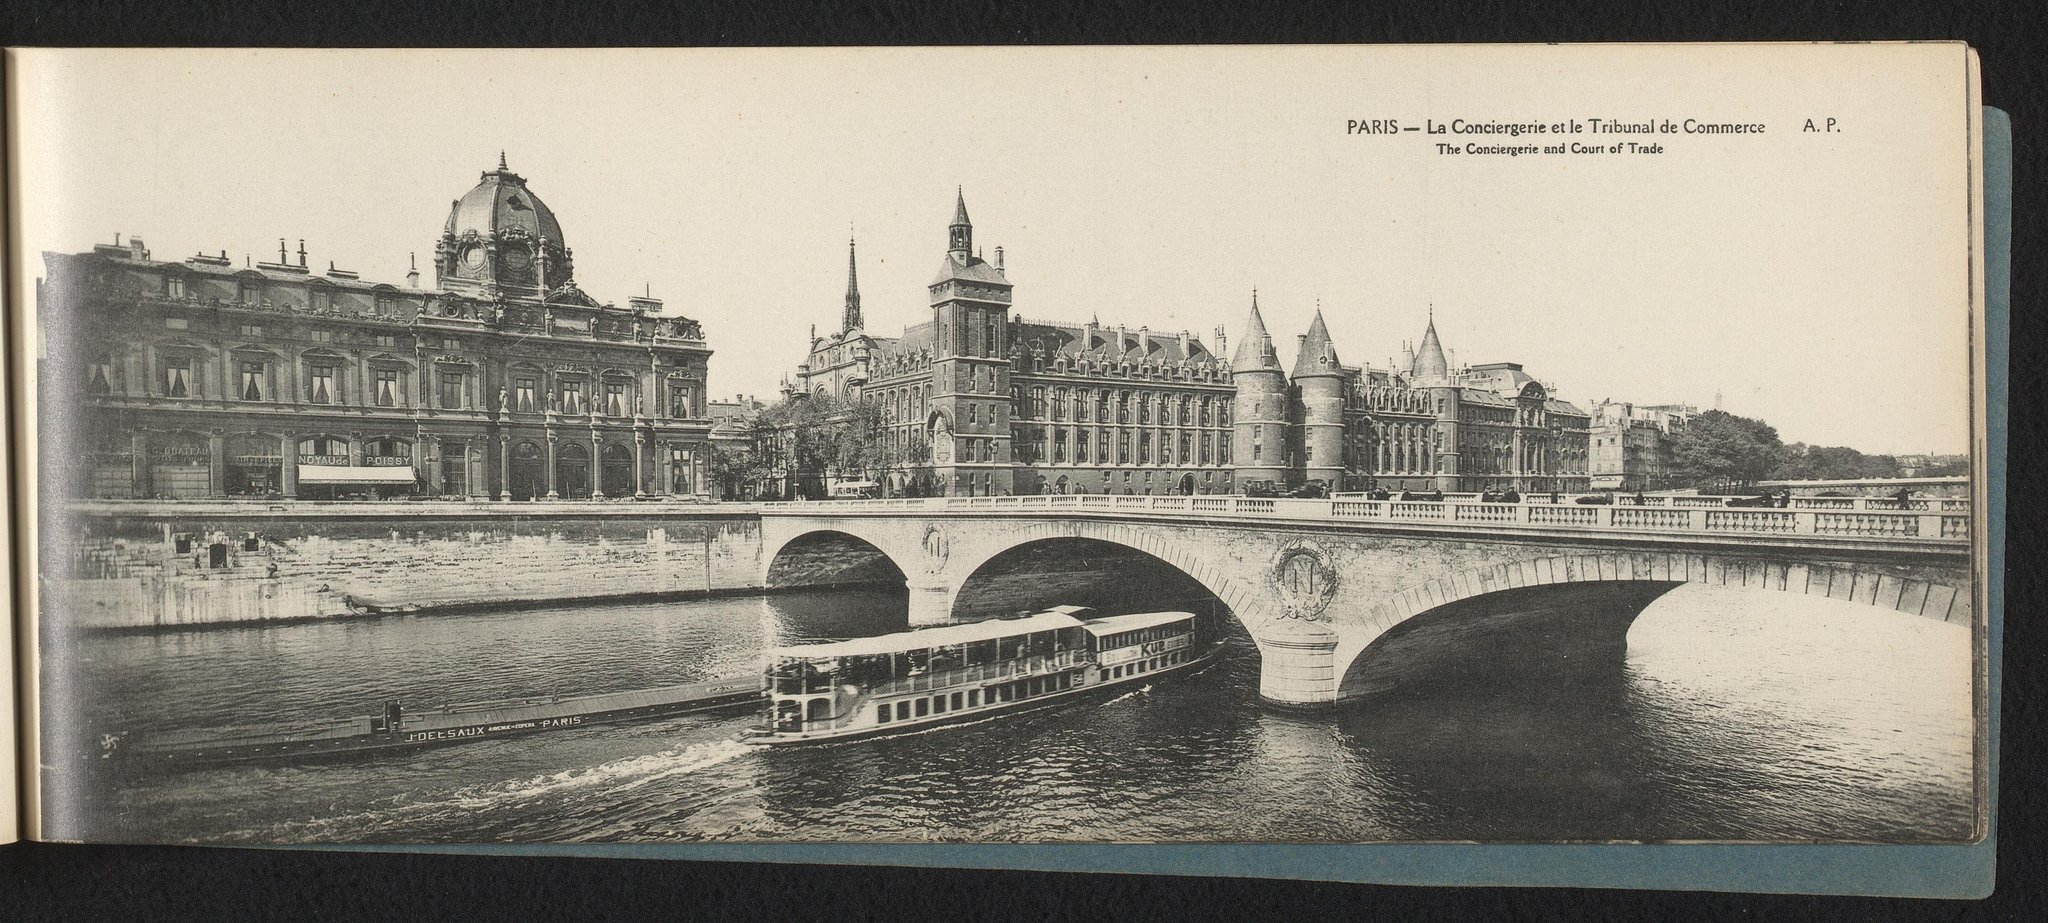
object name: photomechanical print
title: Paris. La conciergerie et le Tribunal de Commerce / The Conciergerie and Court of Trade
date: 1910-1925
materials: cardboard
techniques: photograph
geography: paris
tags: bridge in city across river, canal, etc. (+ city(-scape) with figures, staffage), city-view, and landscape with man-made constructions (+ city(-scape) with figures, staffage)